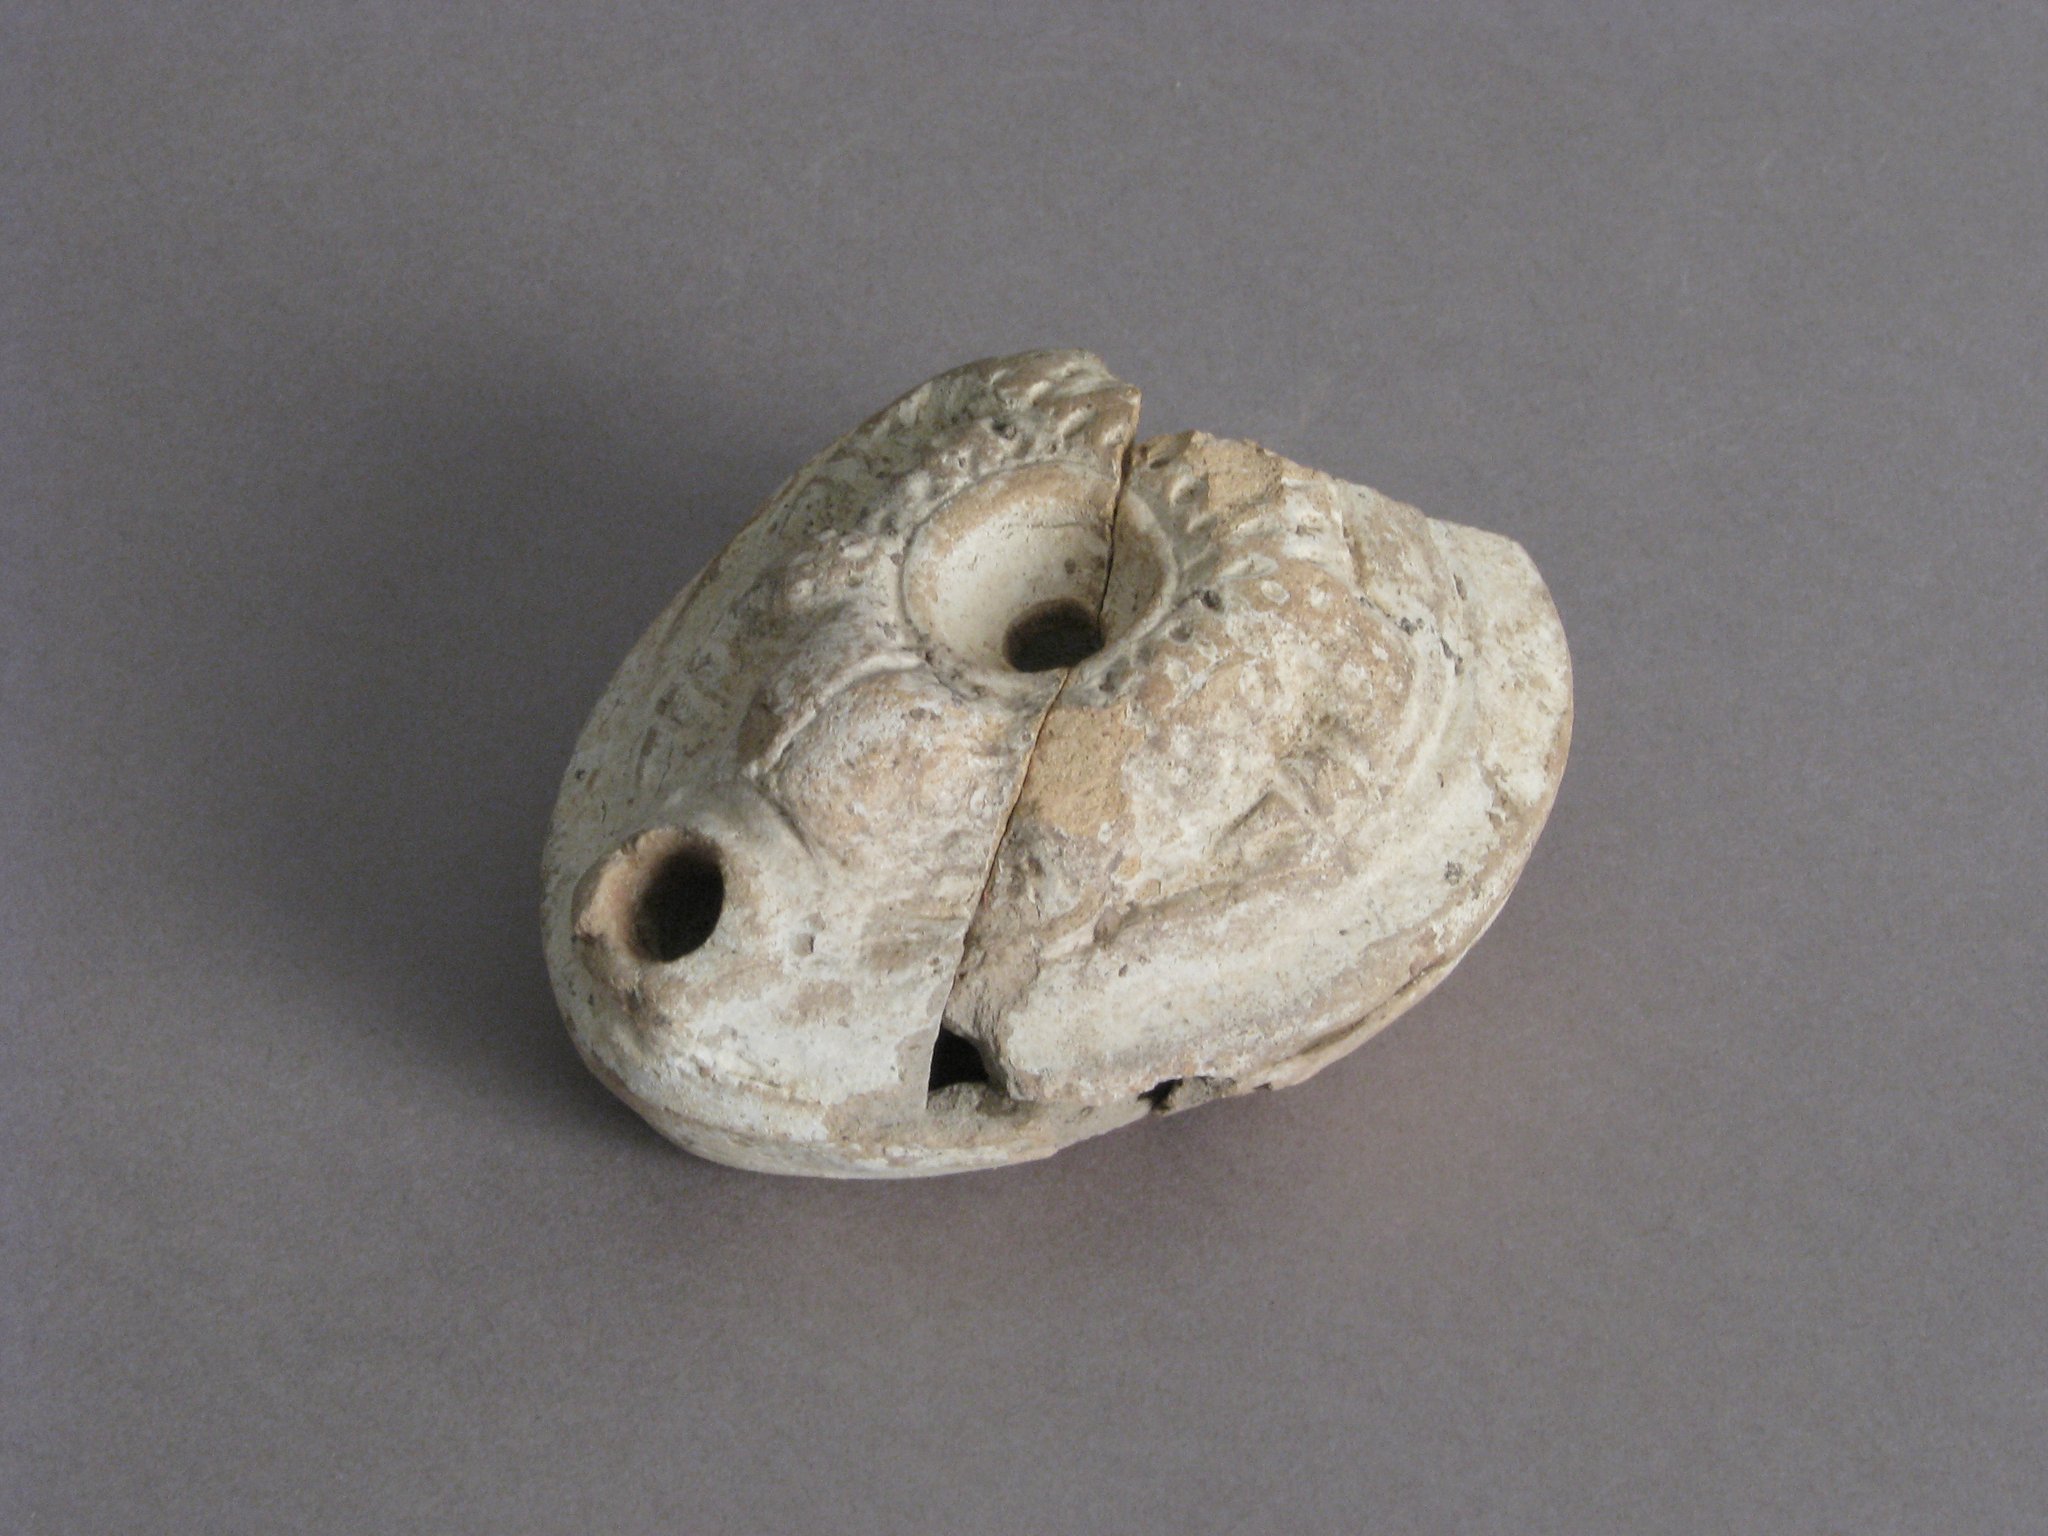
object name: lamp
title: Fragment of an Oil Lamp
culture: coptic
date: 301-700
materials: earthenware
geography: egypt